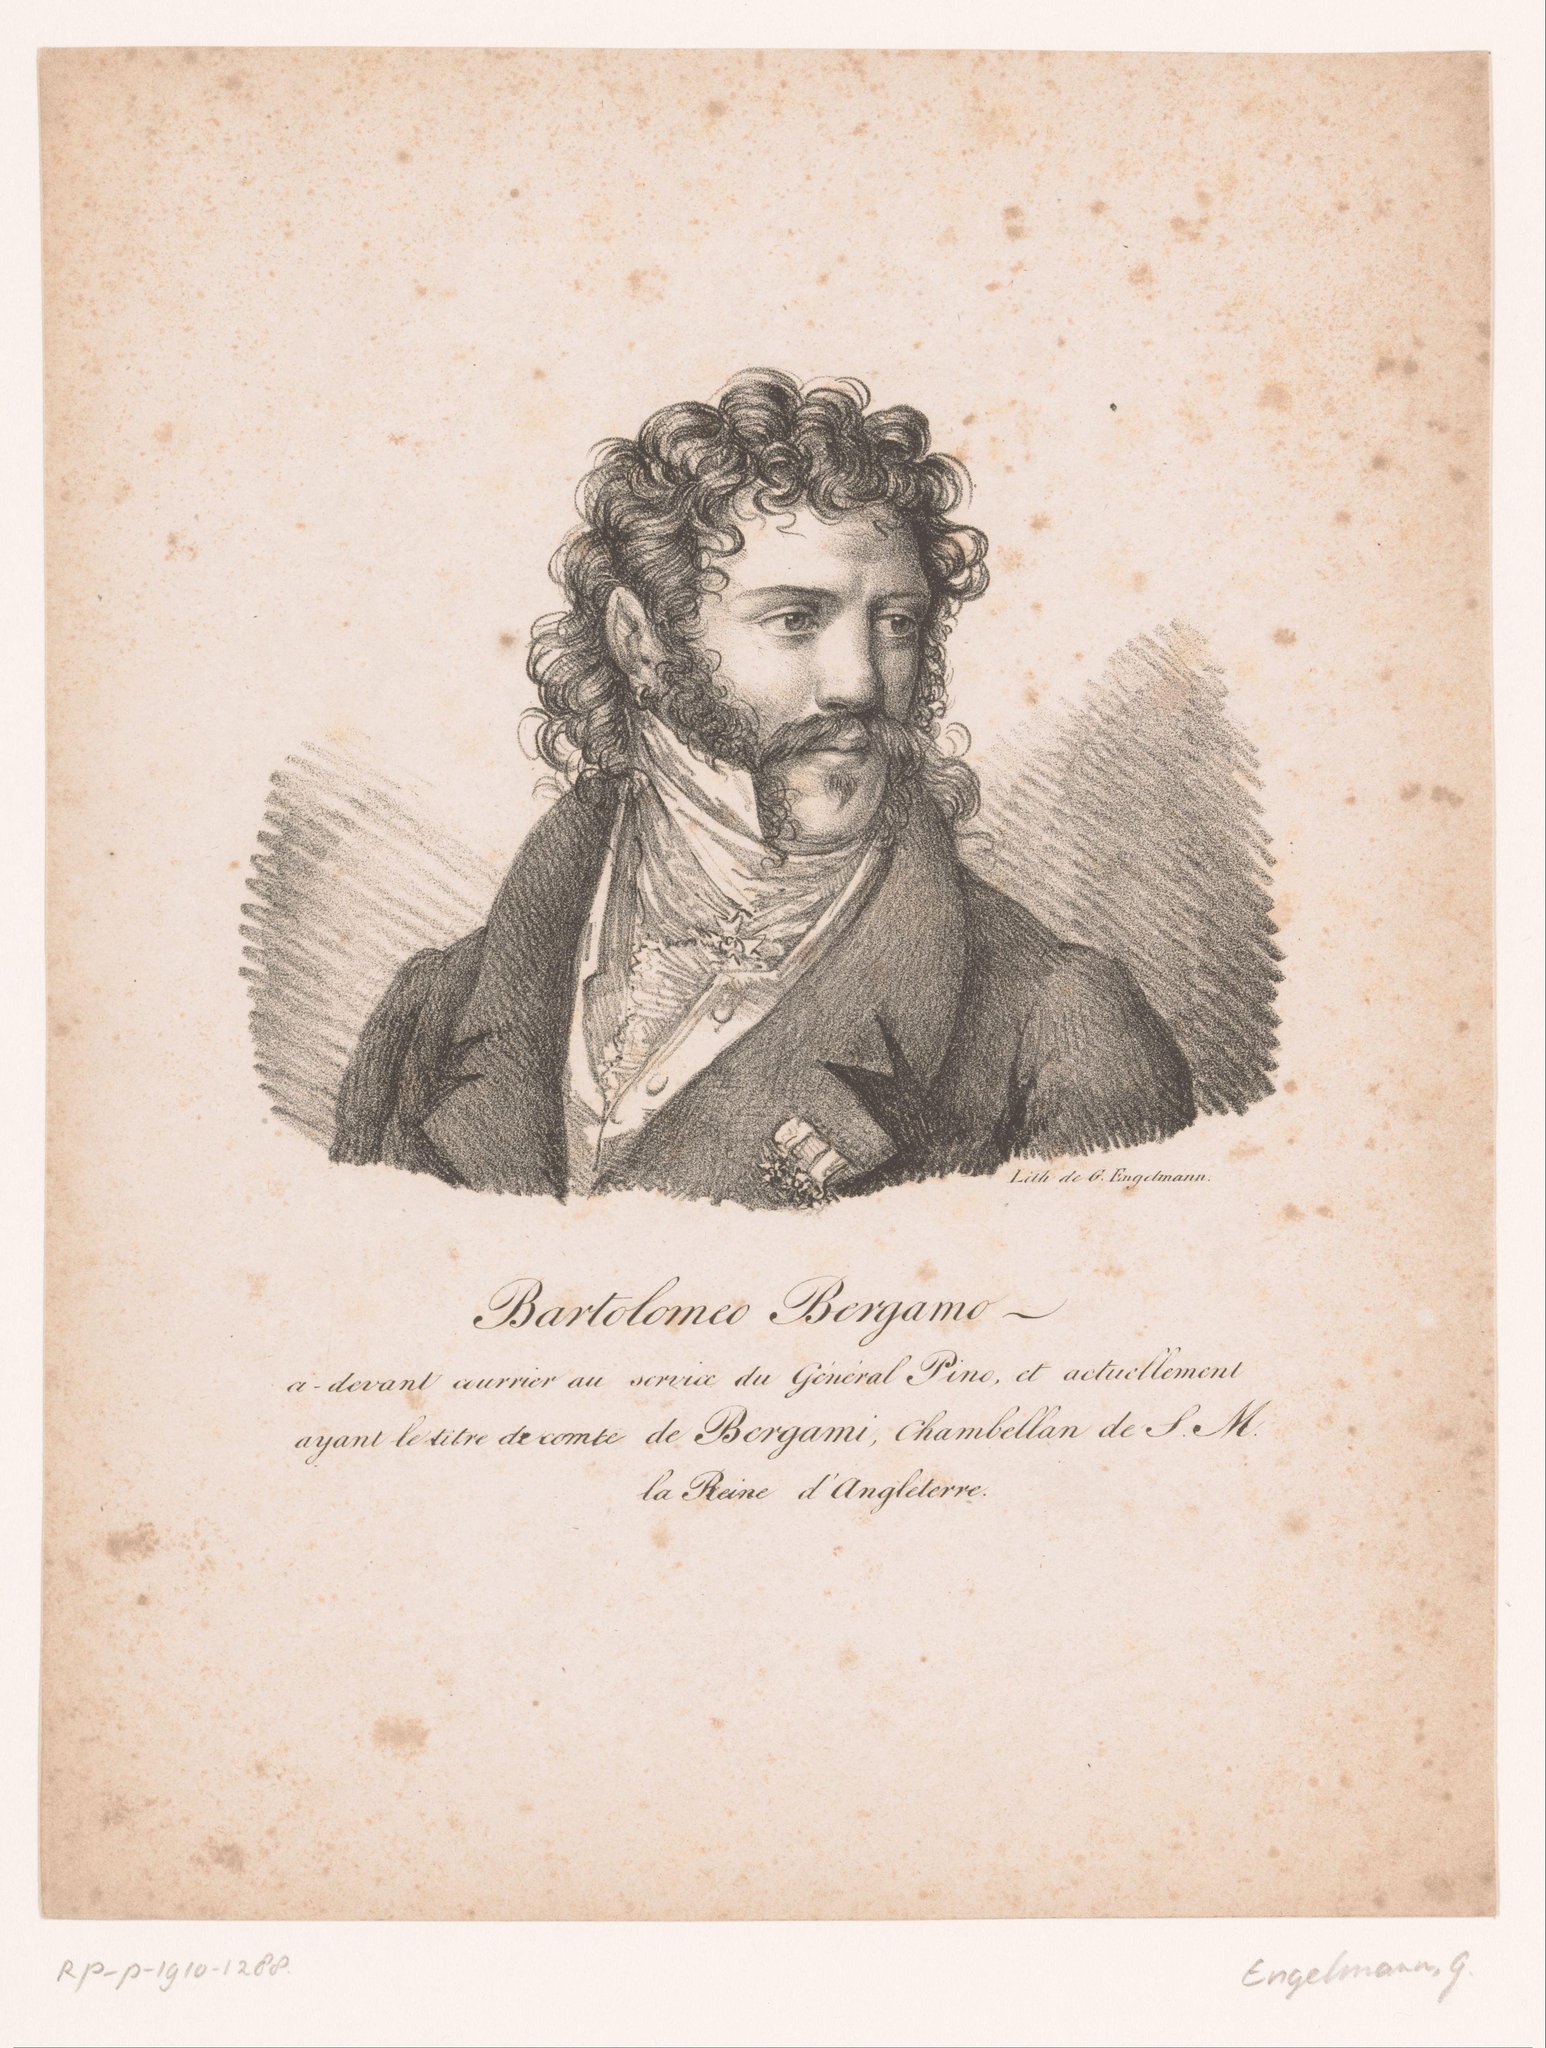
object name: print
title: Portret van Bartolomeo Bergami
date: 1820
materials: paper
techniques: lithograph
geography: paris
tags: earl, historical persons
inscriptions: collector's mark: Lugt 2228a